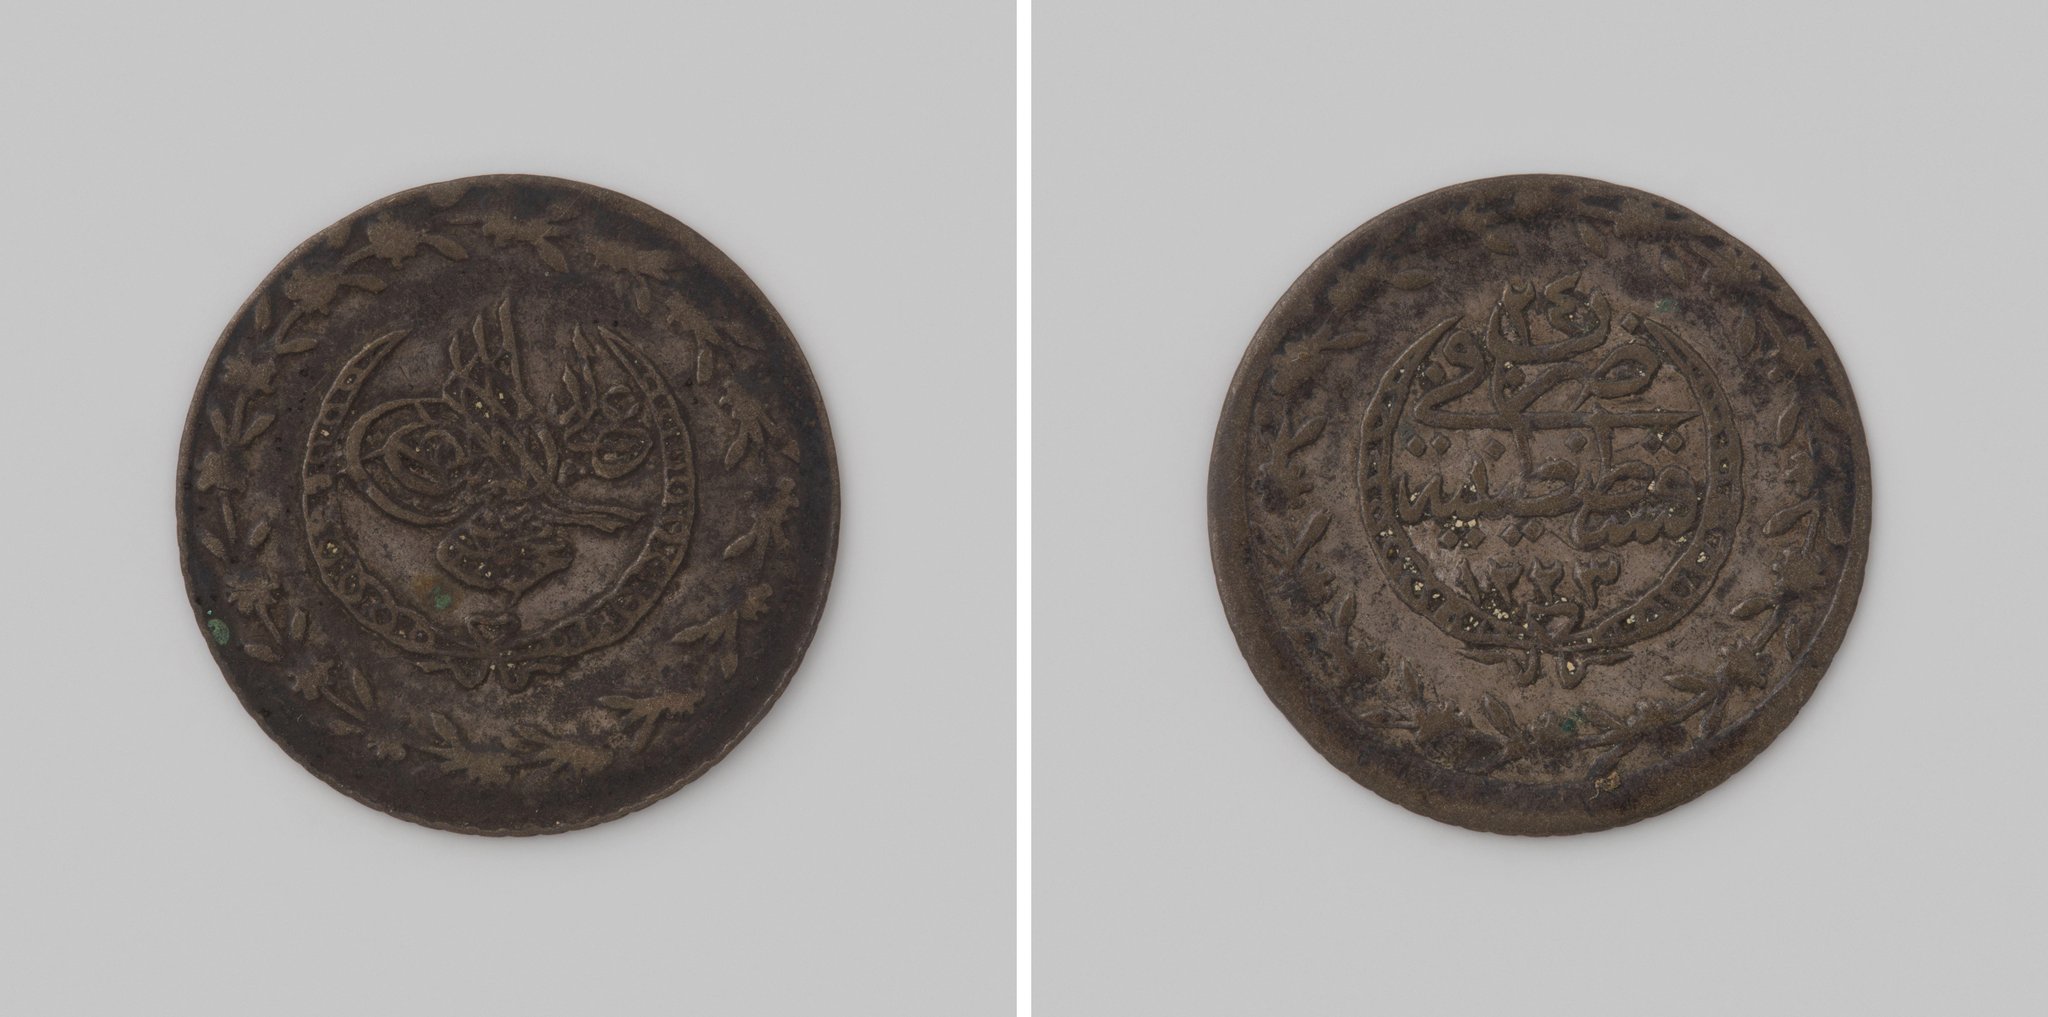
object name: coin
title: 20 para uit Turkije van sultan Mahmud II, regeringsjaar 24 =1831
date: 1831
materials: silver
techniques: striking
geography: constantinople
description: Zilveren munt. Voorzijde: binnen bloemenrand tussen twee samengebonden halve manen tughra met rechts daarvan opschrift: adli. Keerzijde: binnen bloemenrand tussen twee samengebonden halve manen in Arabische letters drieregelig opschrift met muntplaats-aanduiding: Constantinopel. Boven in opschrift regeringsjaar: 24. Onderaan jaar van aantreden:1223 [=1808].